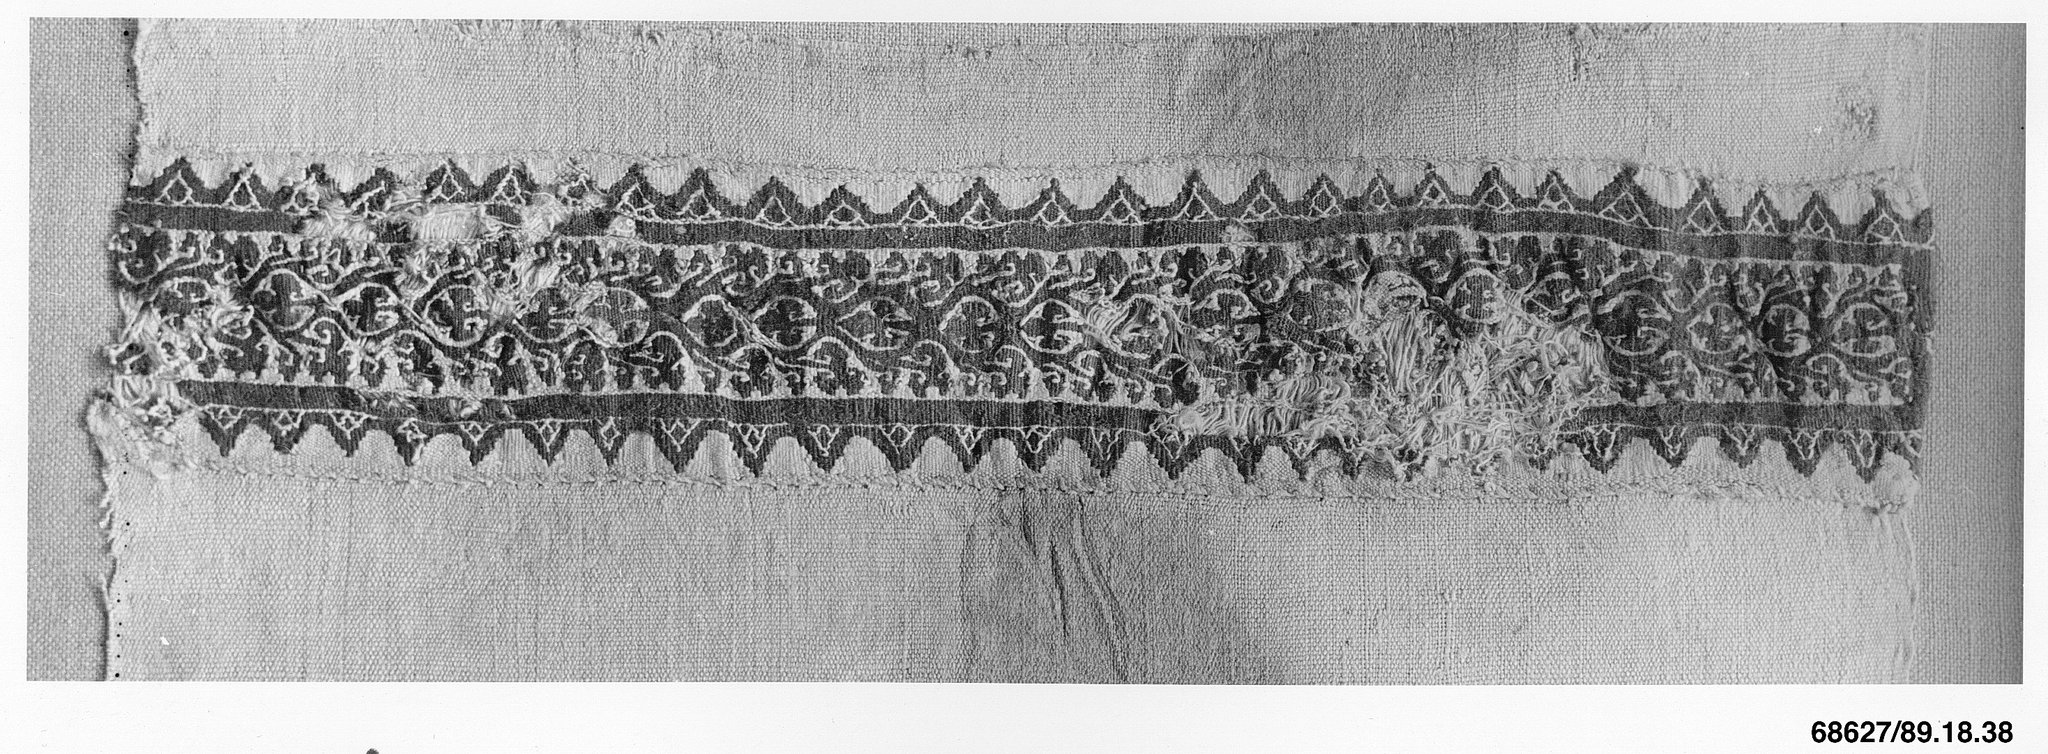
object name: textile fragment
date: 201-400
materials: linen, wool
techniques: weave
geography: egypt